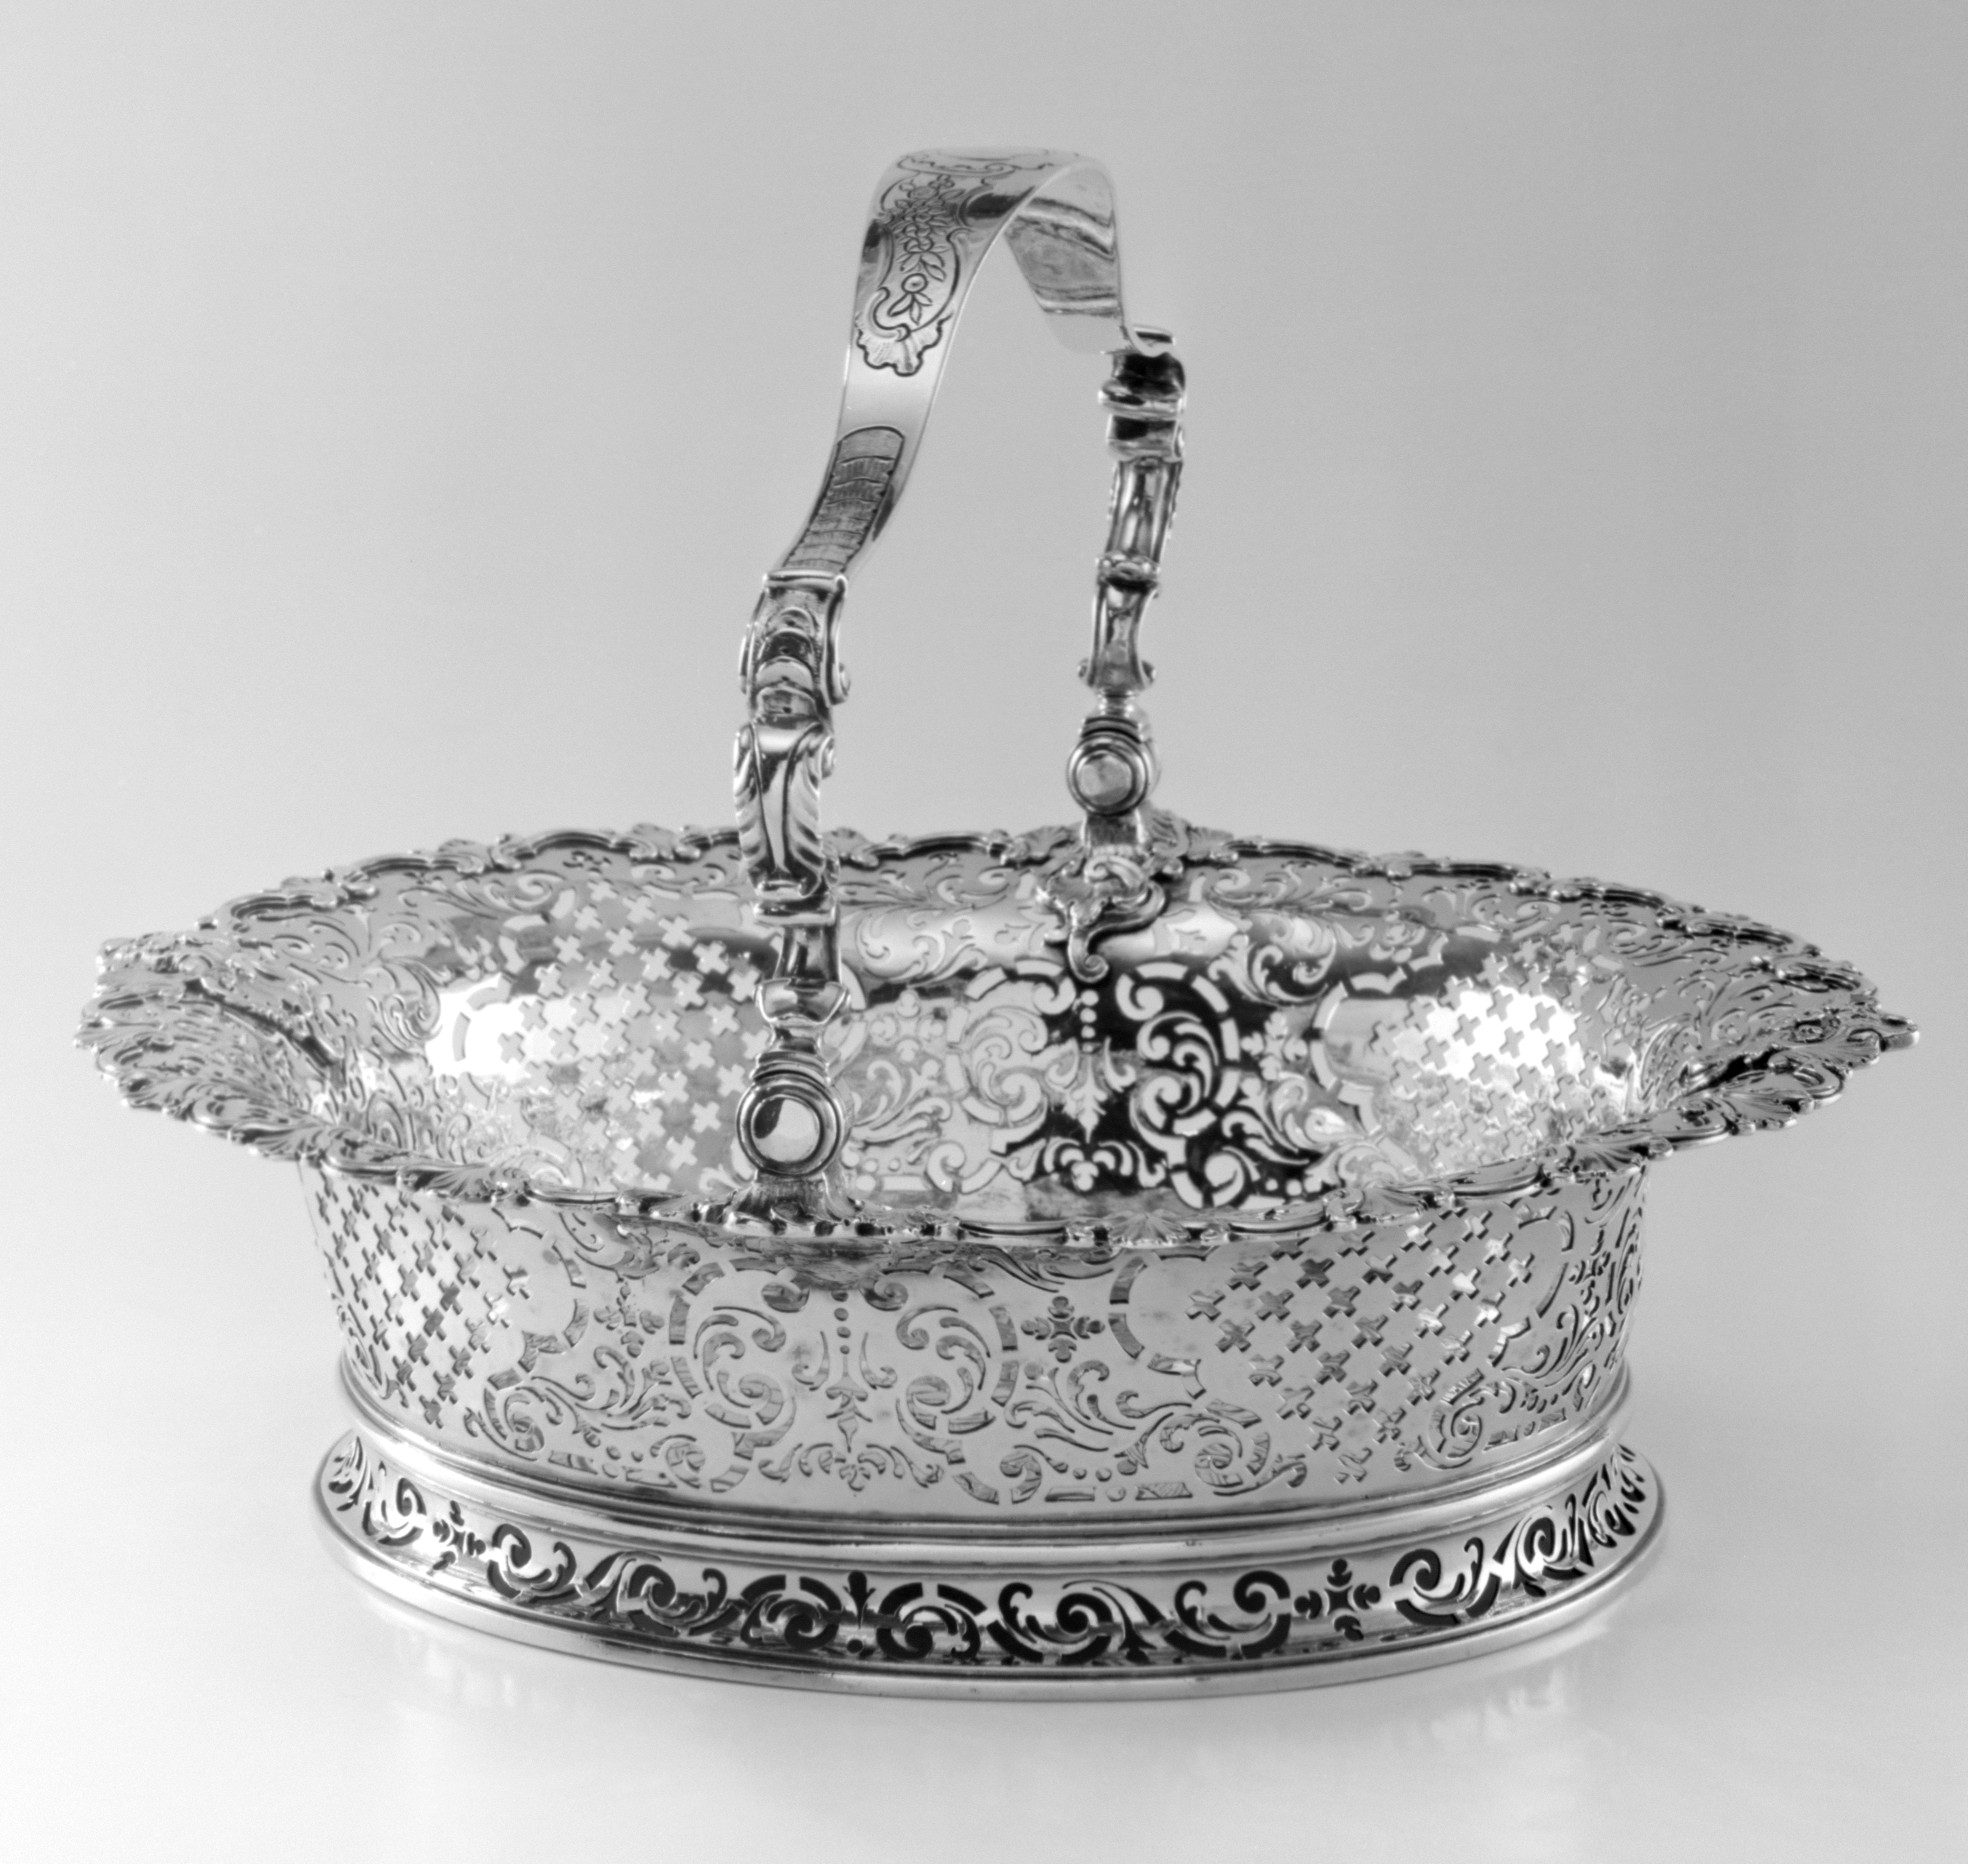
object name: fruit basket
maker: david willaume ii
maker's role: maker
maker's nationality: british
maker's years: 1693-1761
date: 1741-1742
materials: silver gilt